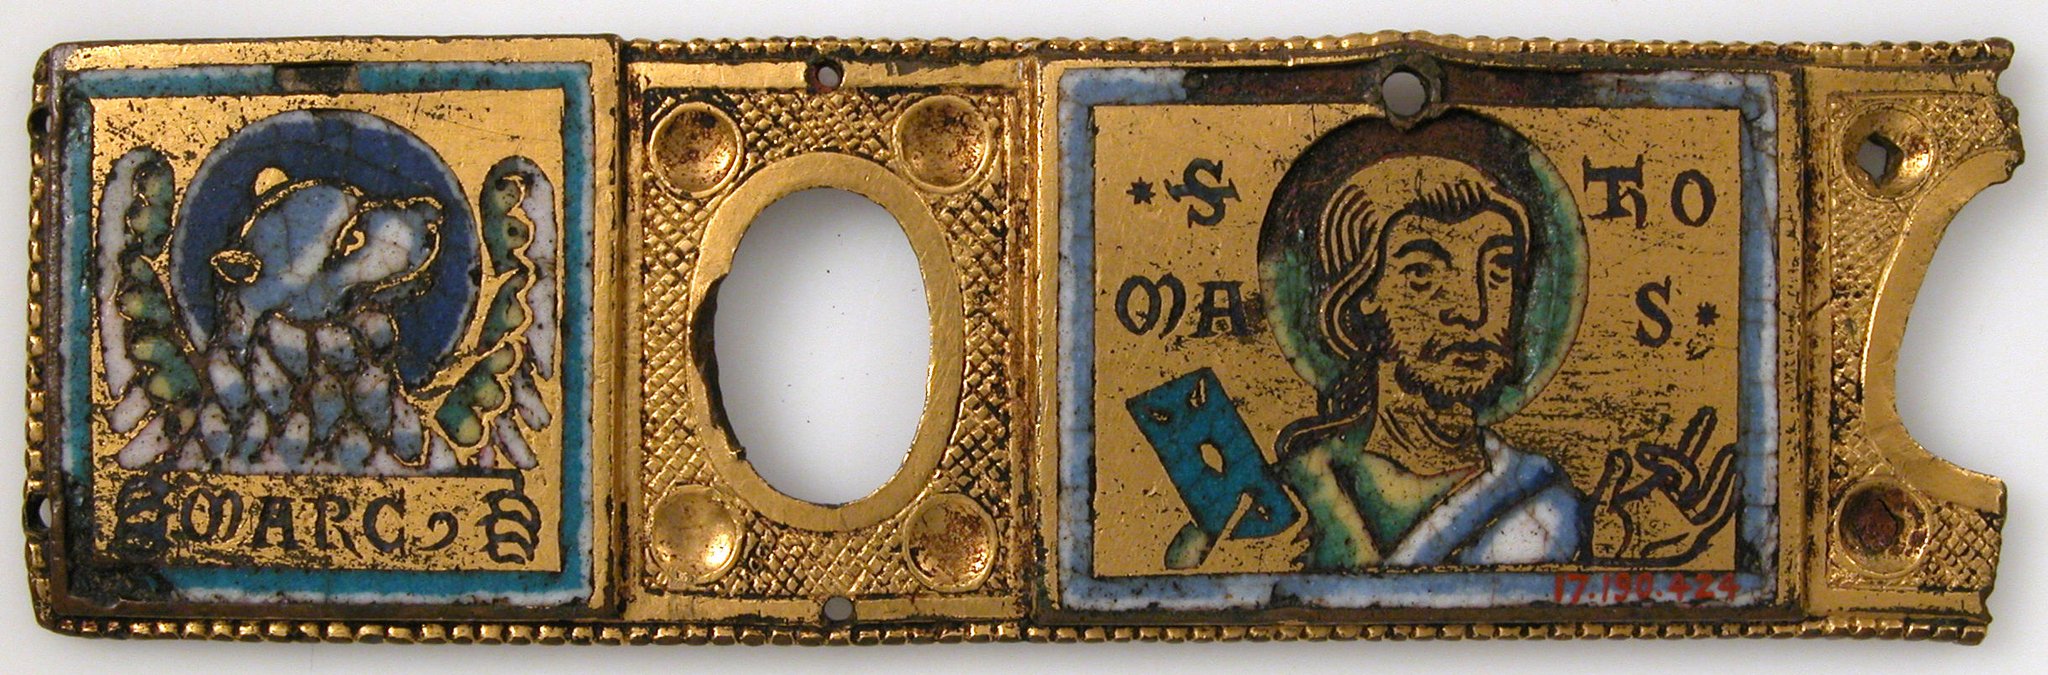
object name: plaque fragment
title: Plaque from a Book Cover or Portable Altar with Saint Thomas and the Lion of Saint Mark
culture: south netherlandish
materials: copper alloy, enamel, gilt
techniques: enamel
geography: netherlands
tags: saints